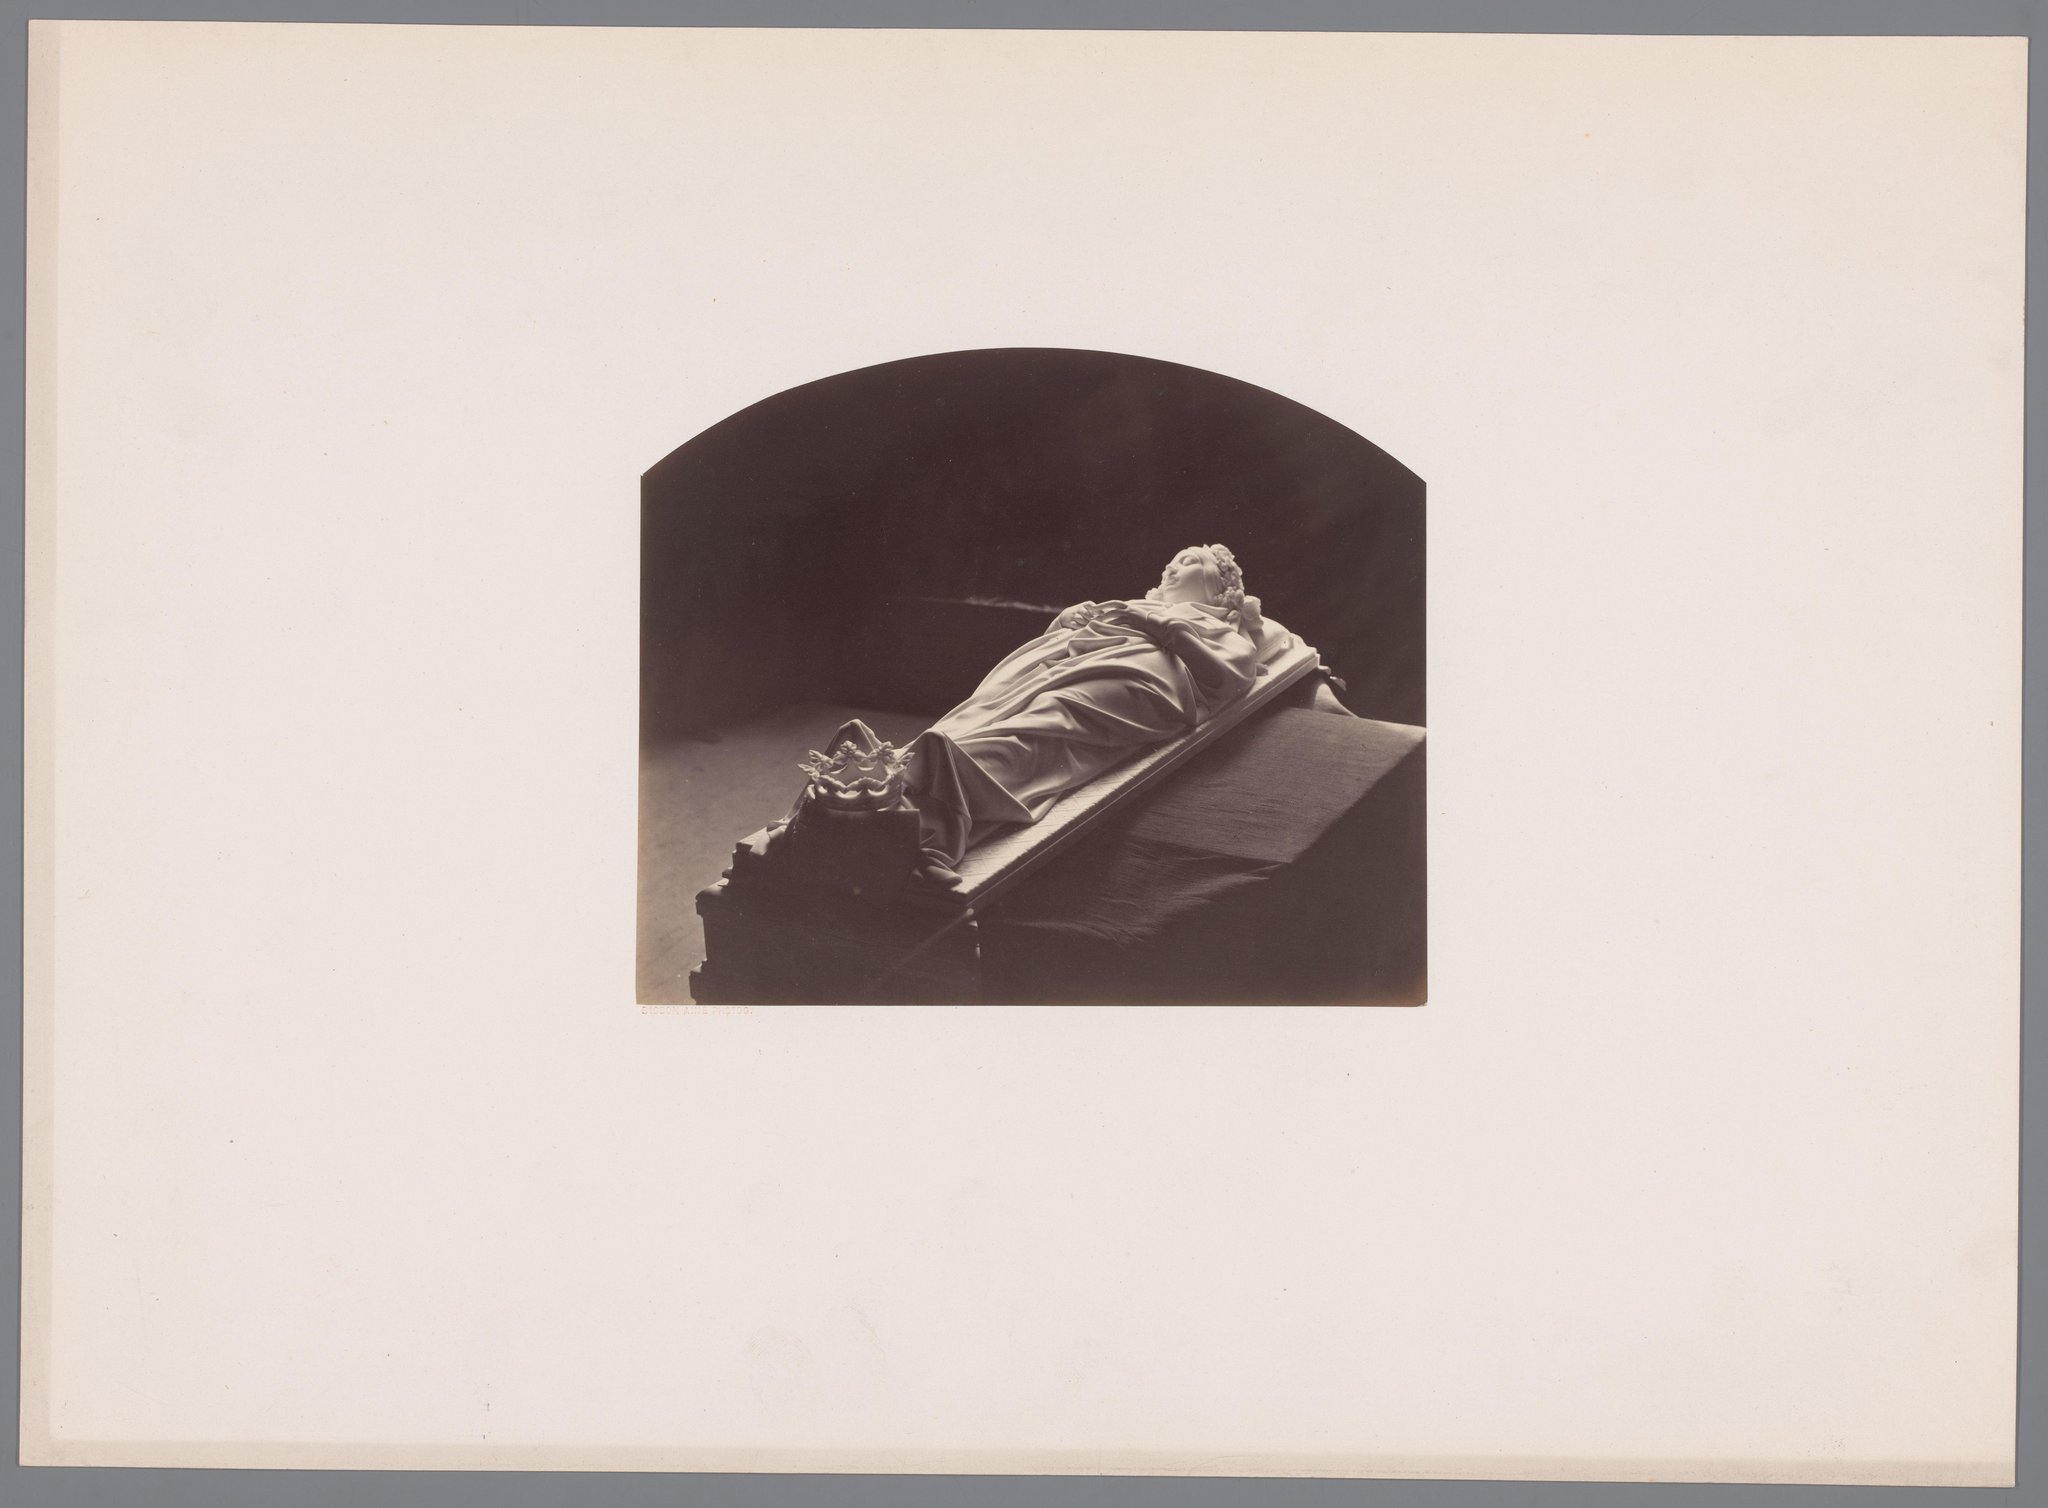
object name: photograph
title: Graftombe van Duchesse de Luynes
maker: louis-auguste bisson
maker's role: fotograaf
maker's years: 1814-1876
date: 1860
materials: cardboard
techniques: albumen print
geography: france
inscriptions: check stamp: ‘Provenance Estate Duc de Luynes’